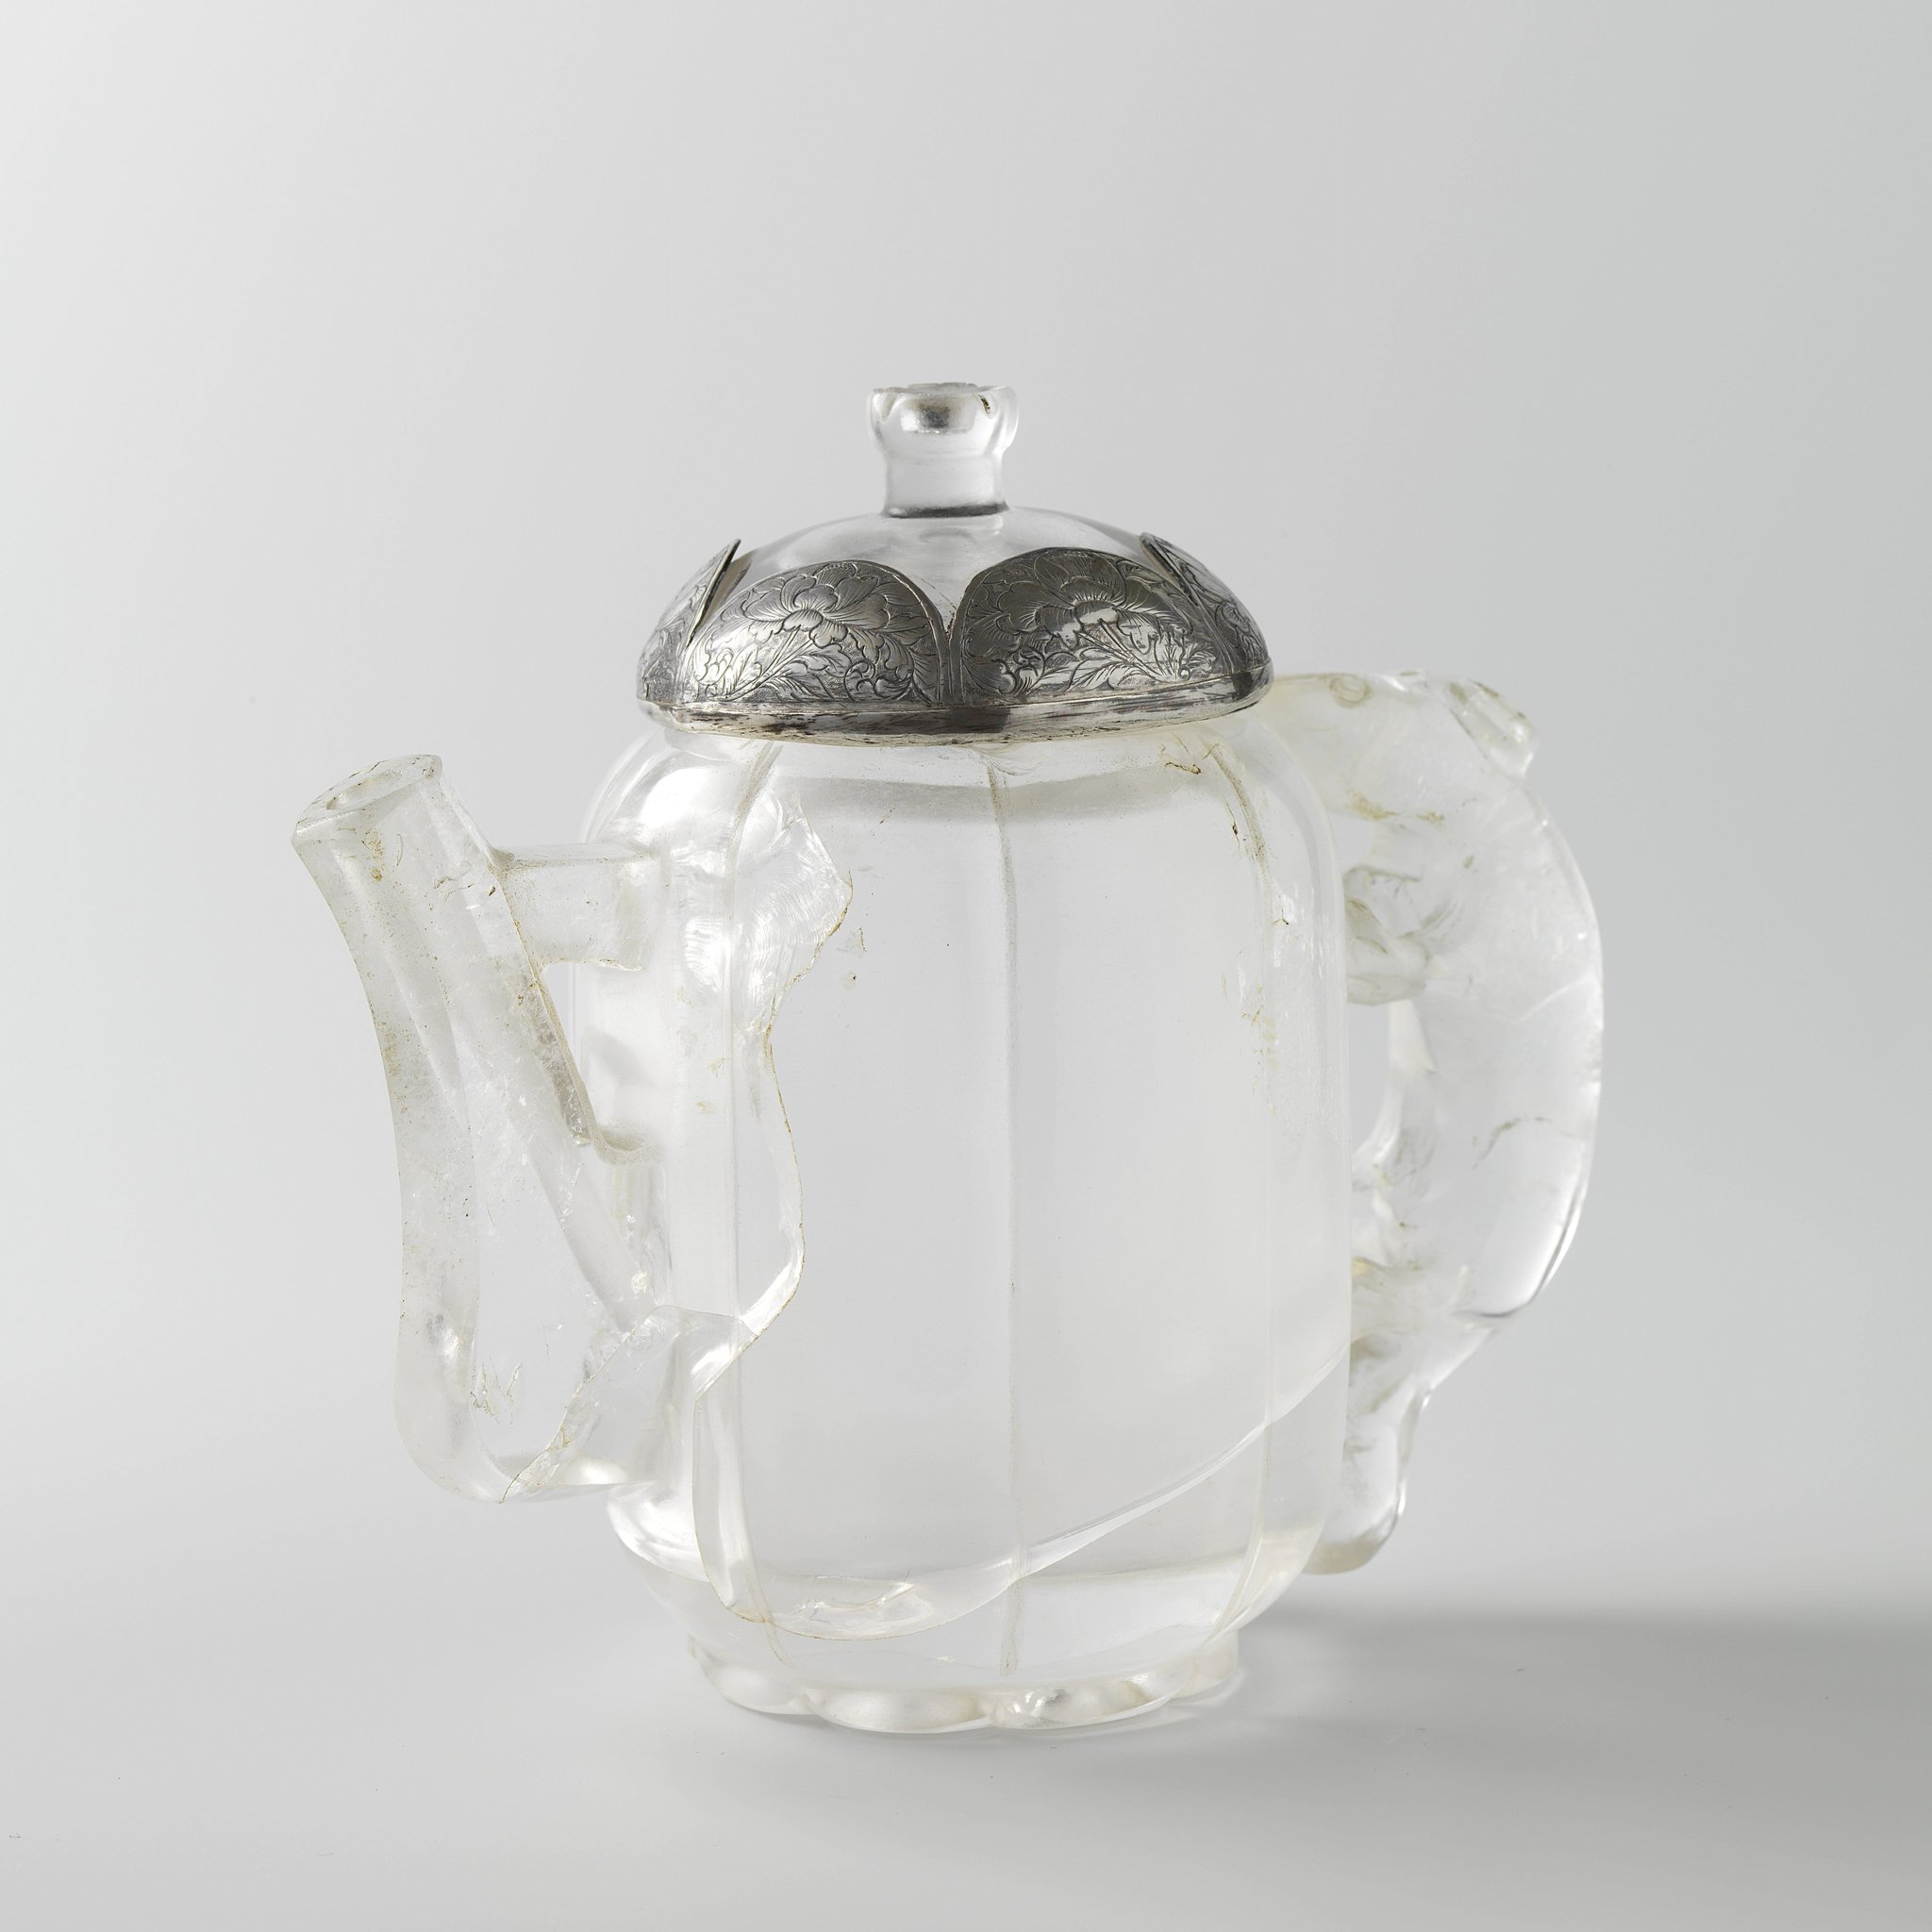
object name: ewer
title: Wine jug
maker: Anonymous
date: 1700-1800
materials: crystal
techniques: bergkristal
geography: china